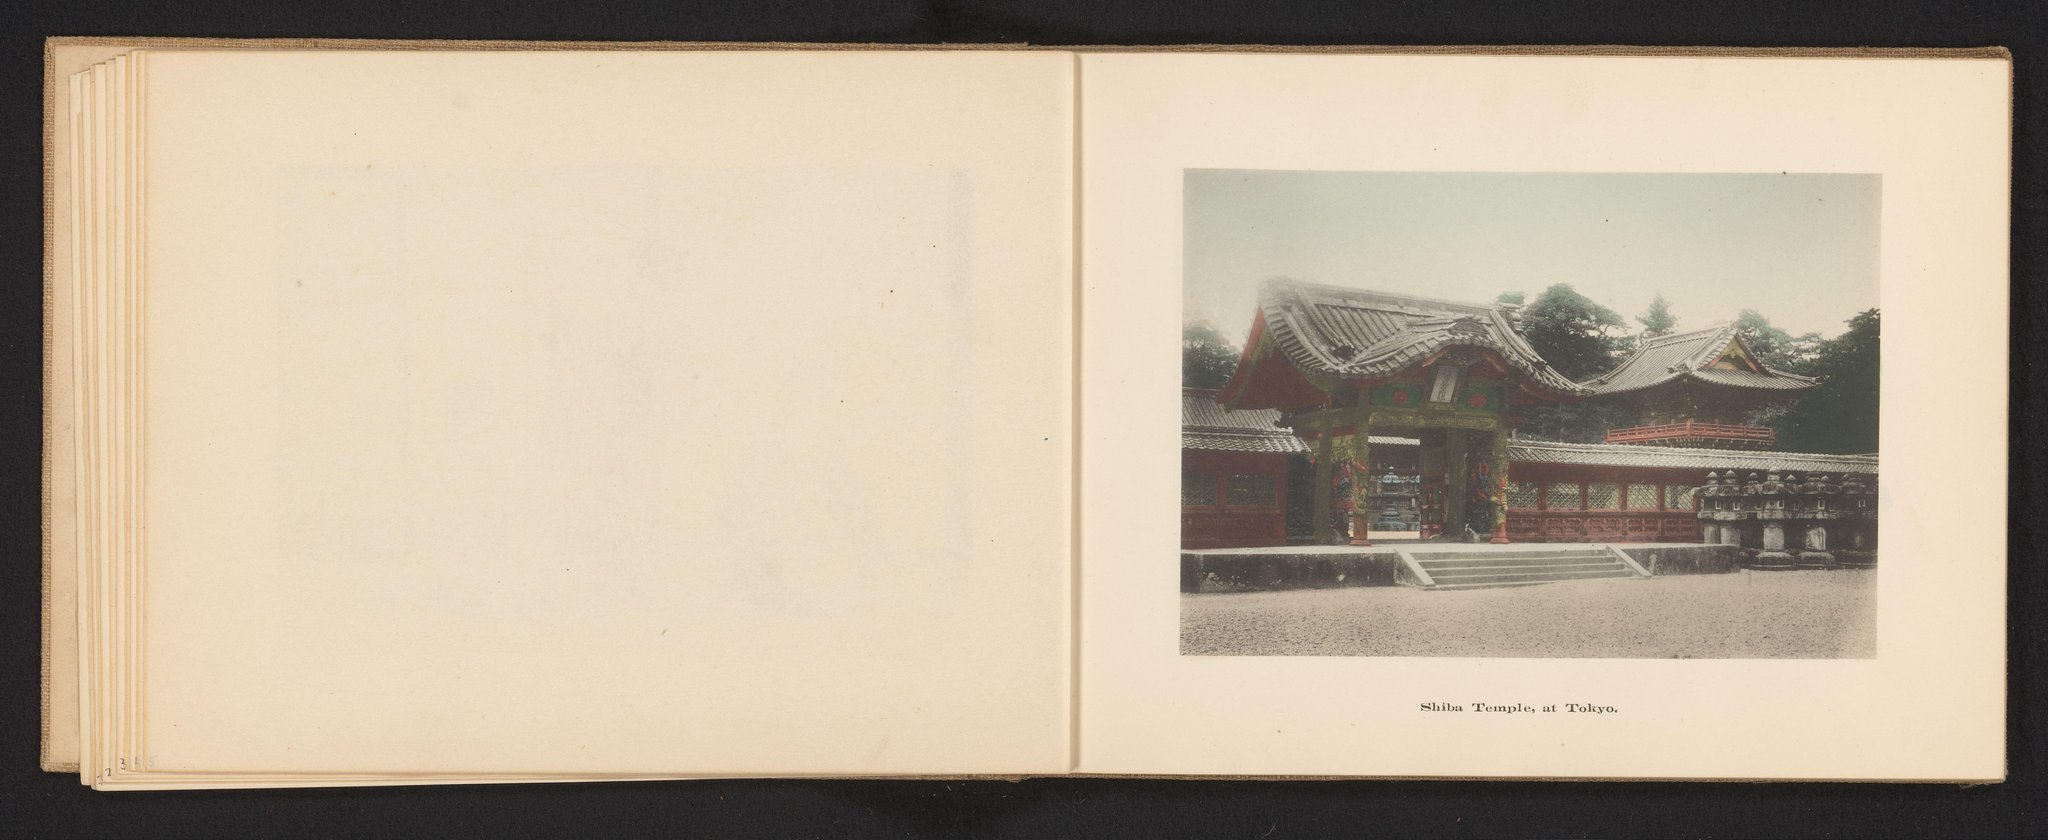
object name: page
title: Shiba Temple, at Tokyo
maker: kōzaburō tamamura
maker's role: fotograaf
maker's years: 1856-1923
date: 1895-1905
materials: paper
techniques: photograph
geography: tokyo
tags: temple, shrine ~ hinduism, buddhism, jainism